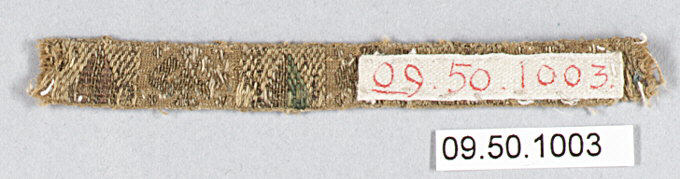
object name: gimp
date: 1401-1600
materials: metal thread, silk